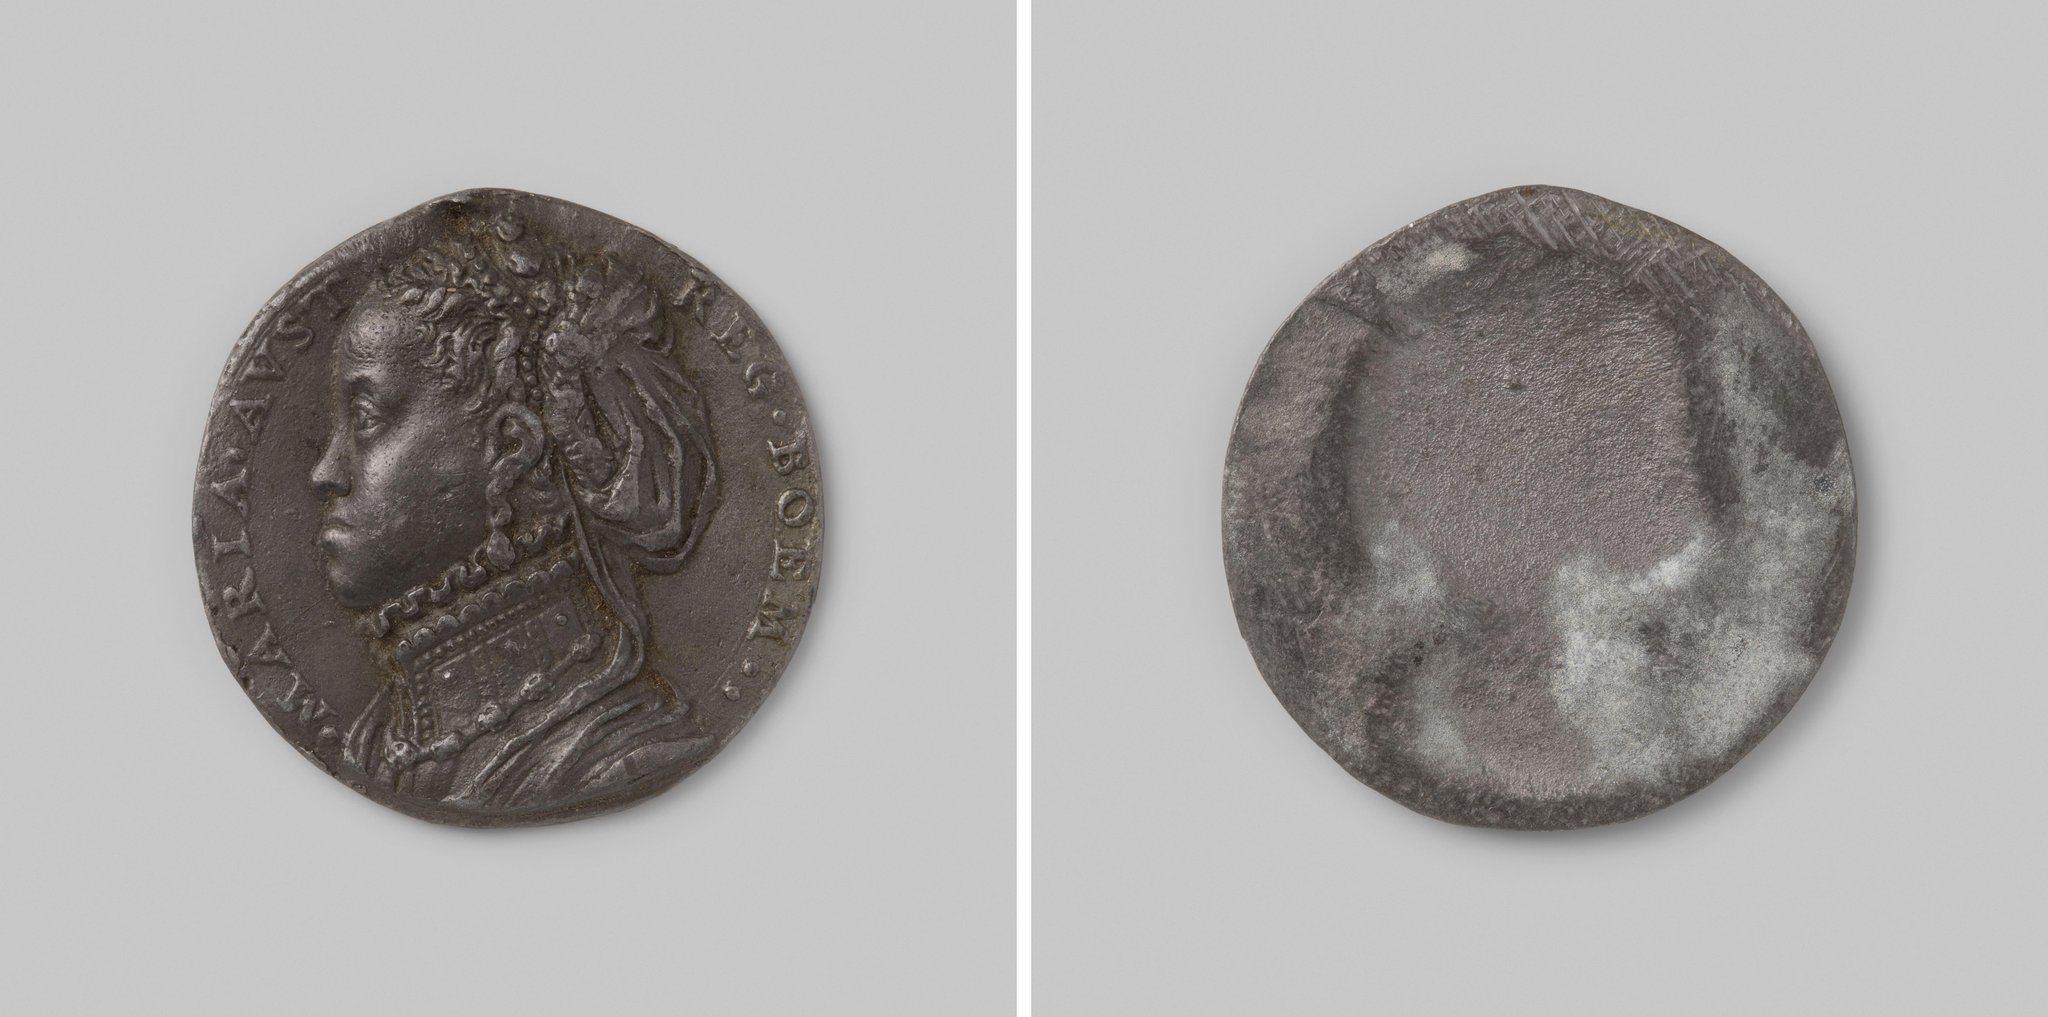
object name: history medal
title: Maria, koningin van Bohemen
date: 1550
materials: lead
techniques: casting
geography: milan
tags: maria (koningin van bohemen)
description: Eenzijdige loden penning. Voorzijde: borststuk vrouw binnen omschrift. Keerzijde: blanco